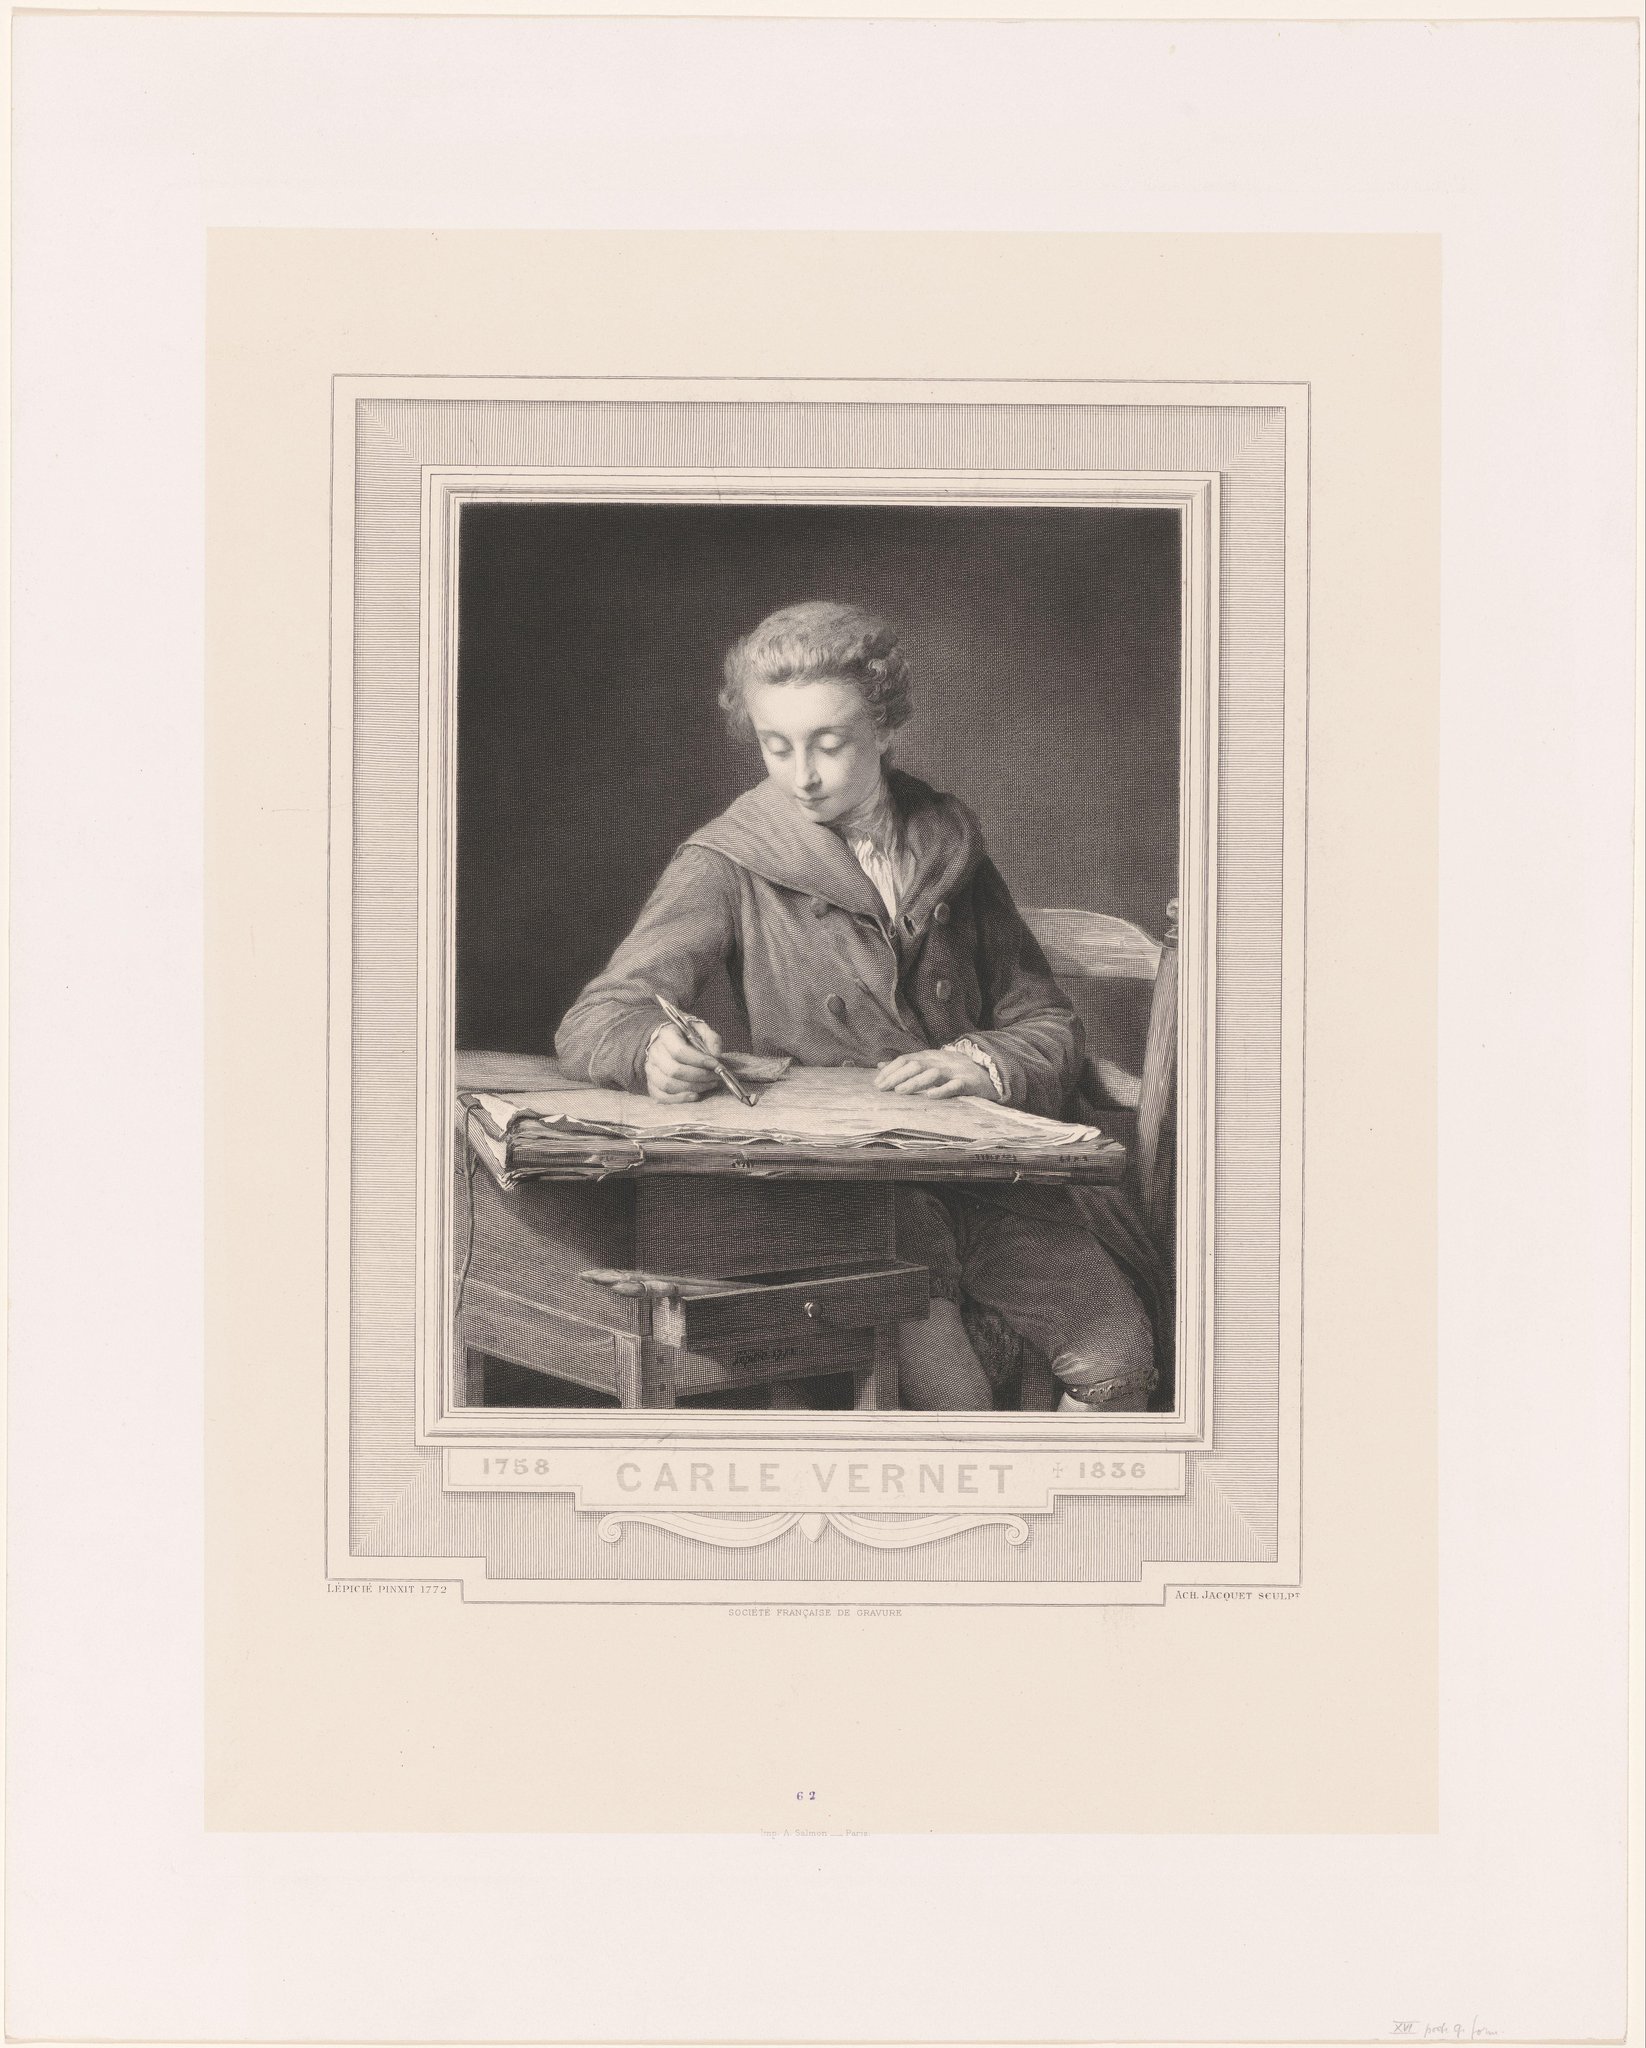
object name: print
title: Carle Vernet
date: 1868-1908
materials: paper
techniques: engraving, etching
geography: paris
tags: paris, print maker, draughtsman, carle vernet, draughtsman at work, artist at work, in his workshop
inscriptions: collector's mark: Lugt 4779, collector's mark: Lugt 2228, number: ‘62’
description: Portret van Carle Vernet op veertienjarige leeftijd, zittend achter een werktafel. In zijn rechterhand heeft hij een krijthouder waarmee hij op een vel papier tekent dat op een portfolio rust.